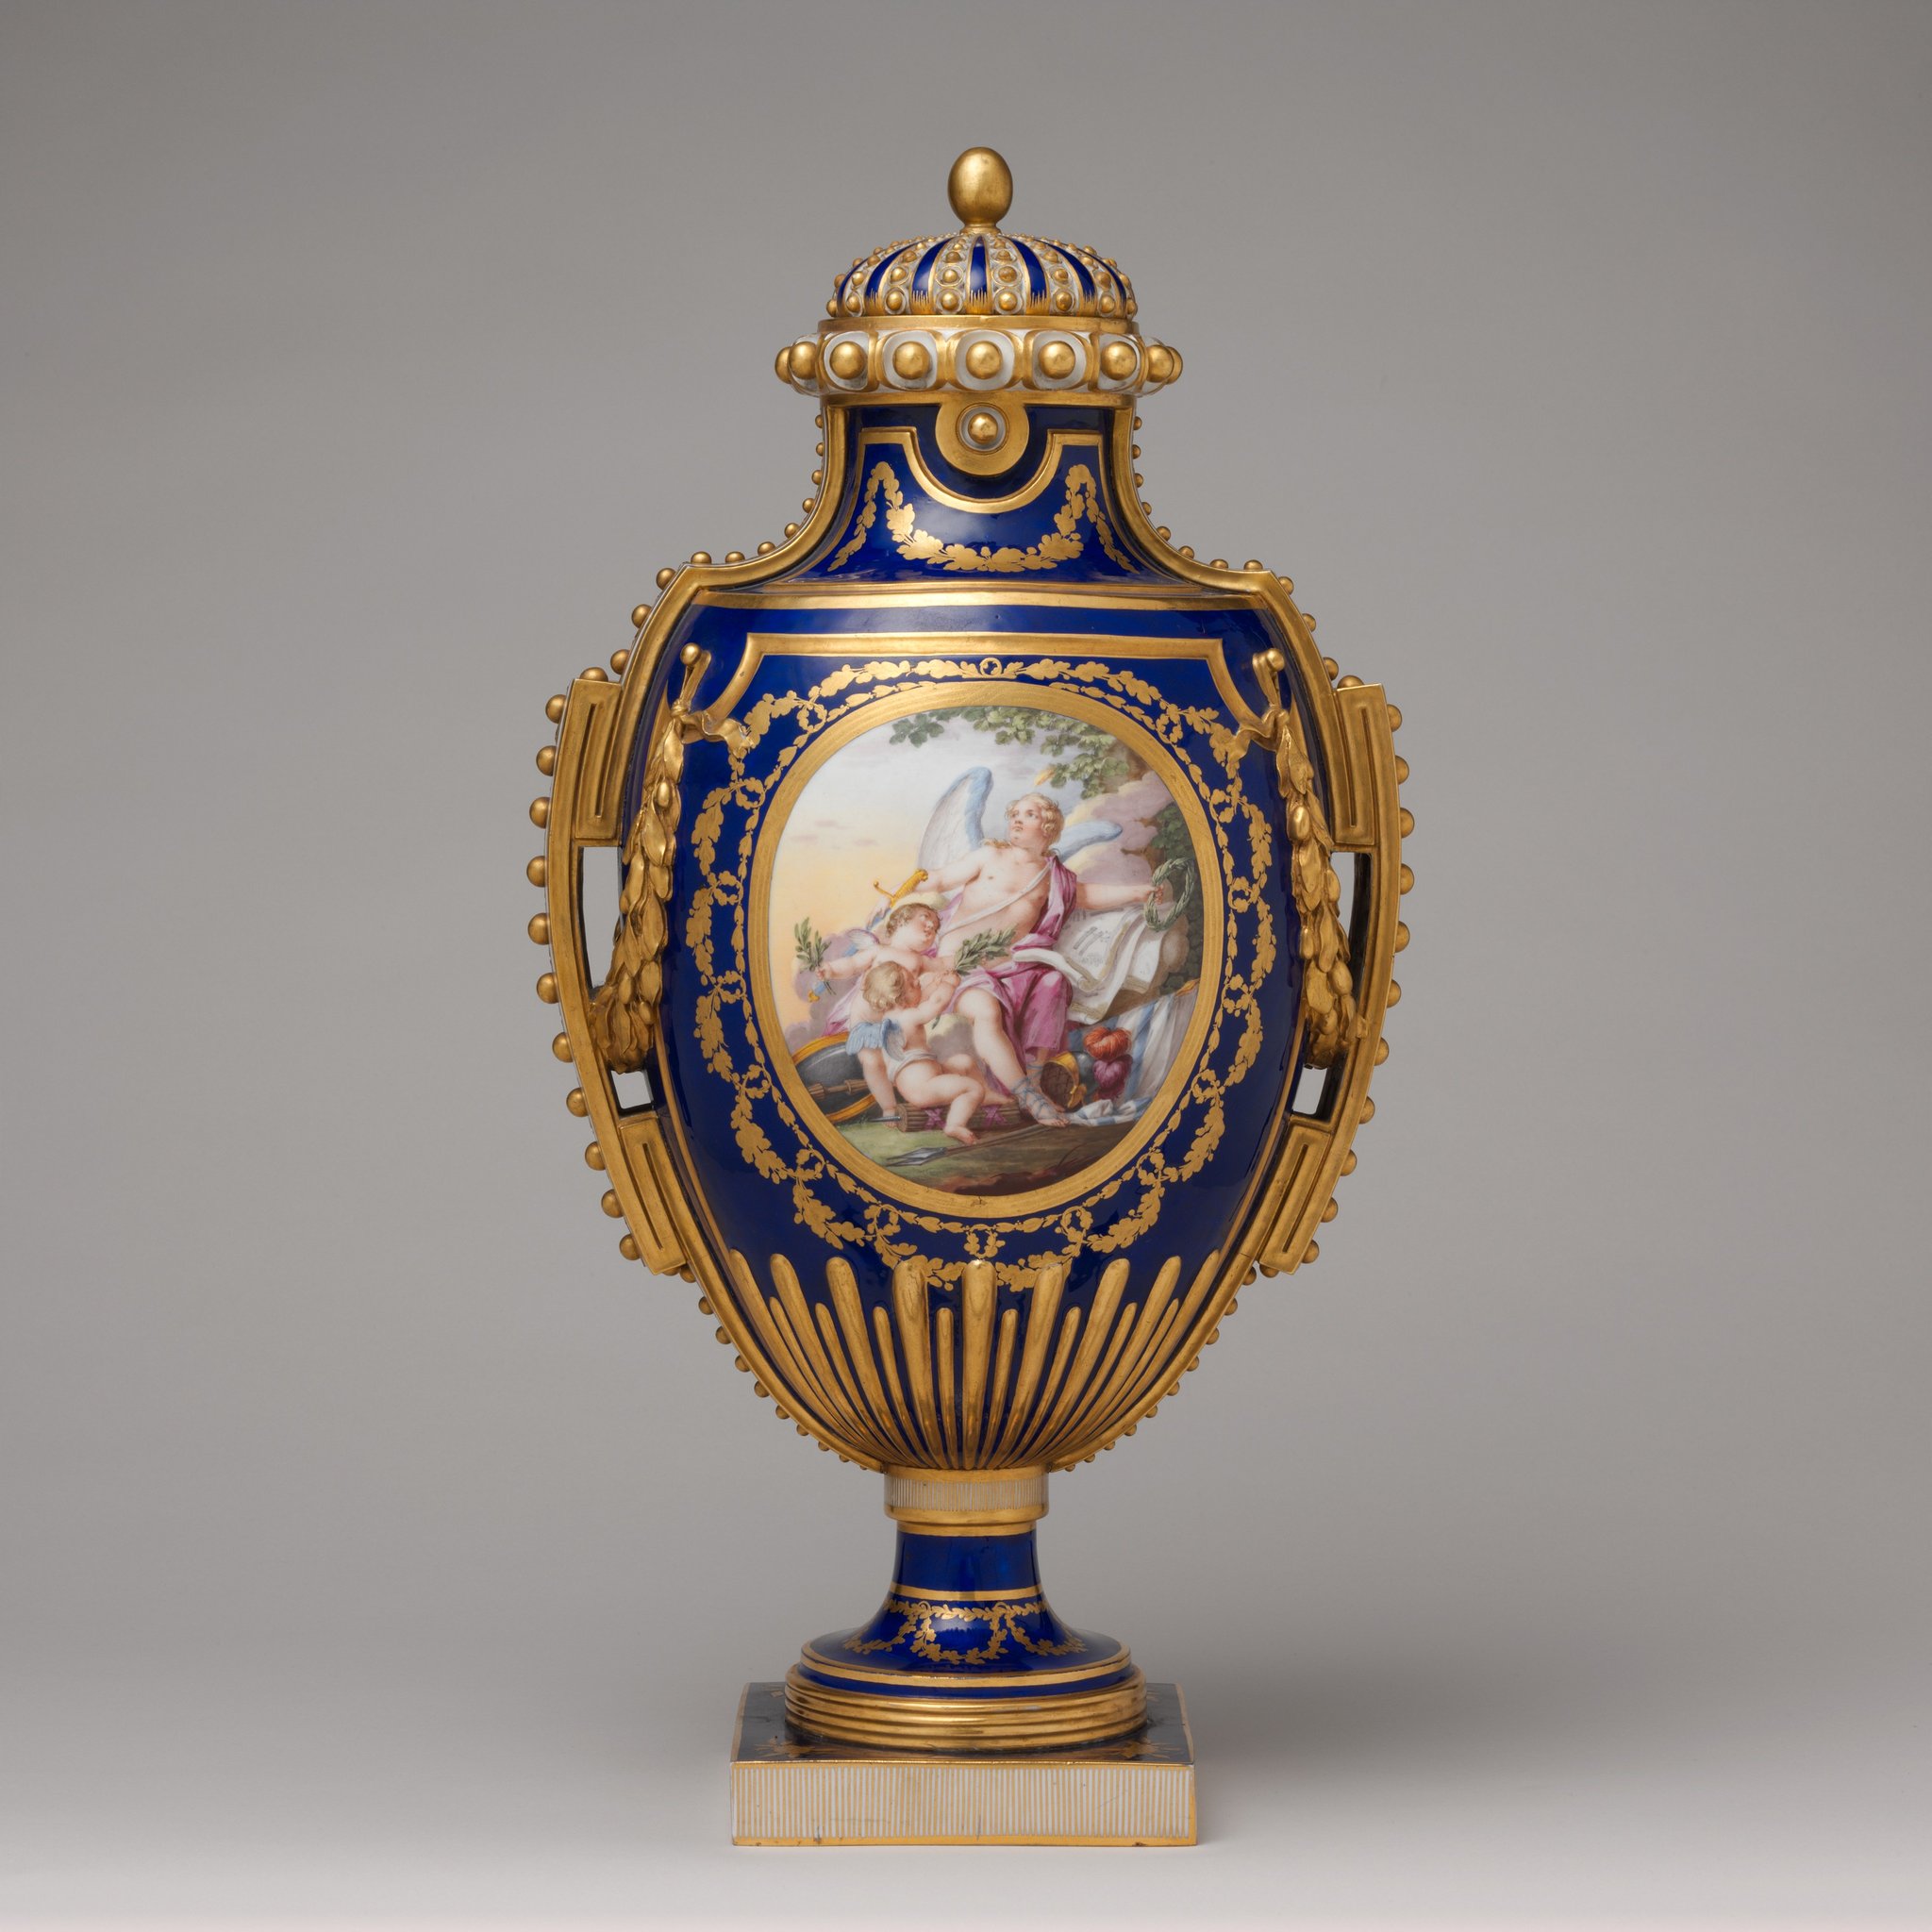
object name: vase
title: Vase (vase à panneaux or à perles)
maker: sèvres manufactory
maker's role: manufactory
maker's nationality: french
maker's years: 1740-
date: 1779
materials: soft paste porcelain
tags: putti